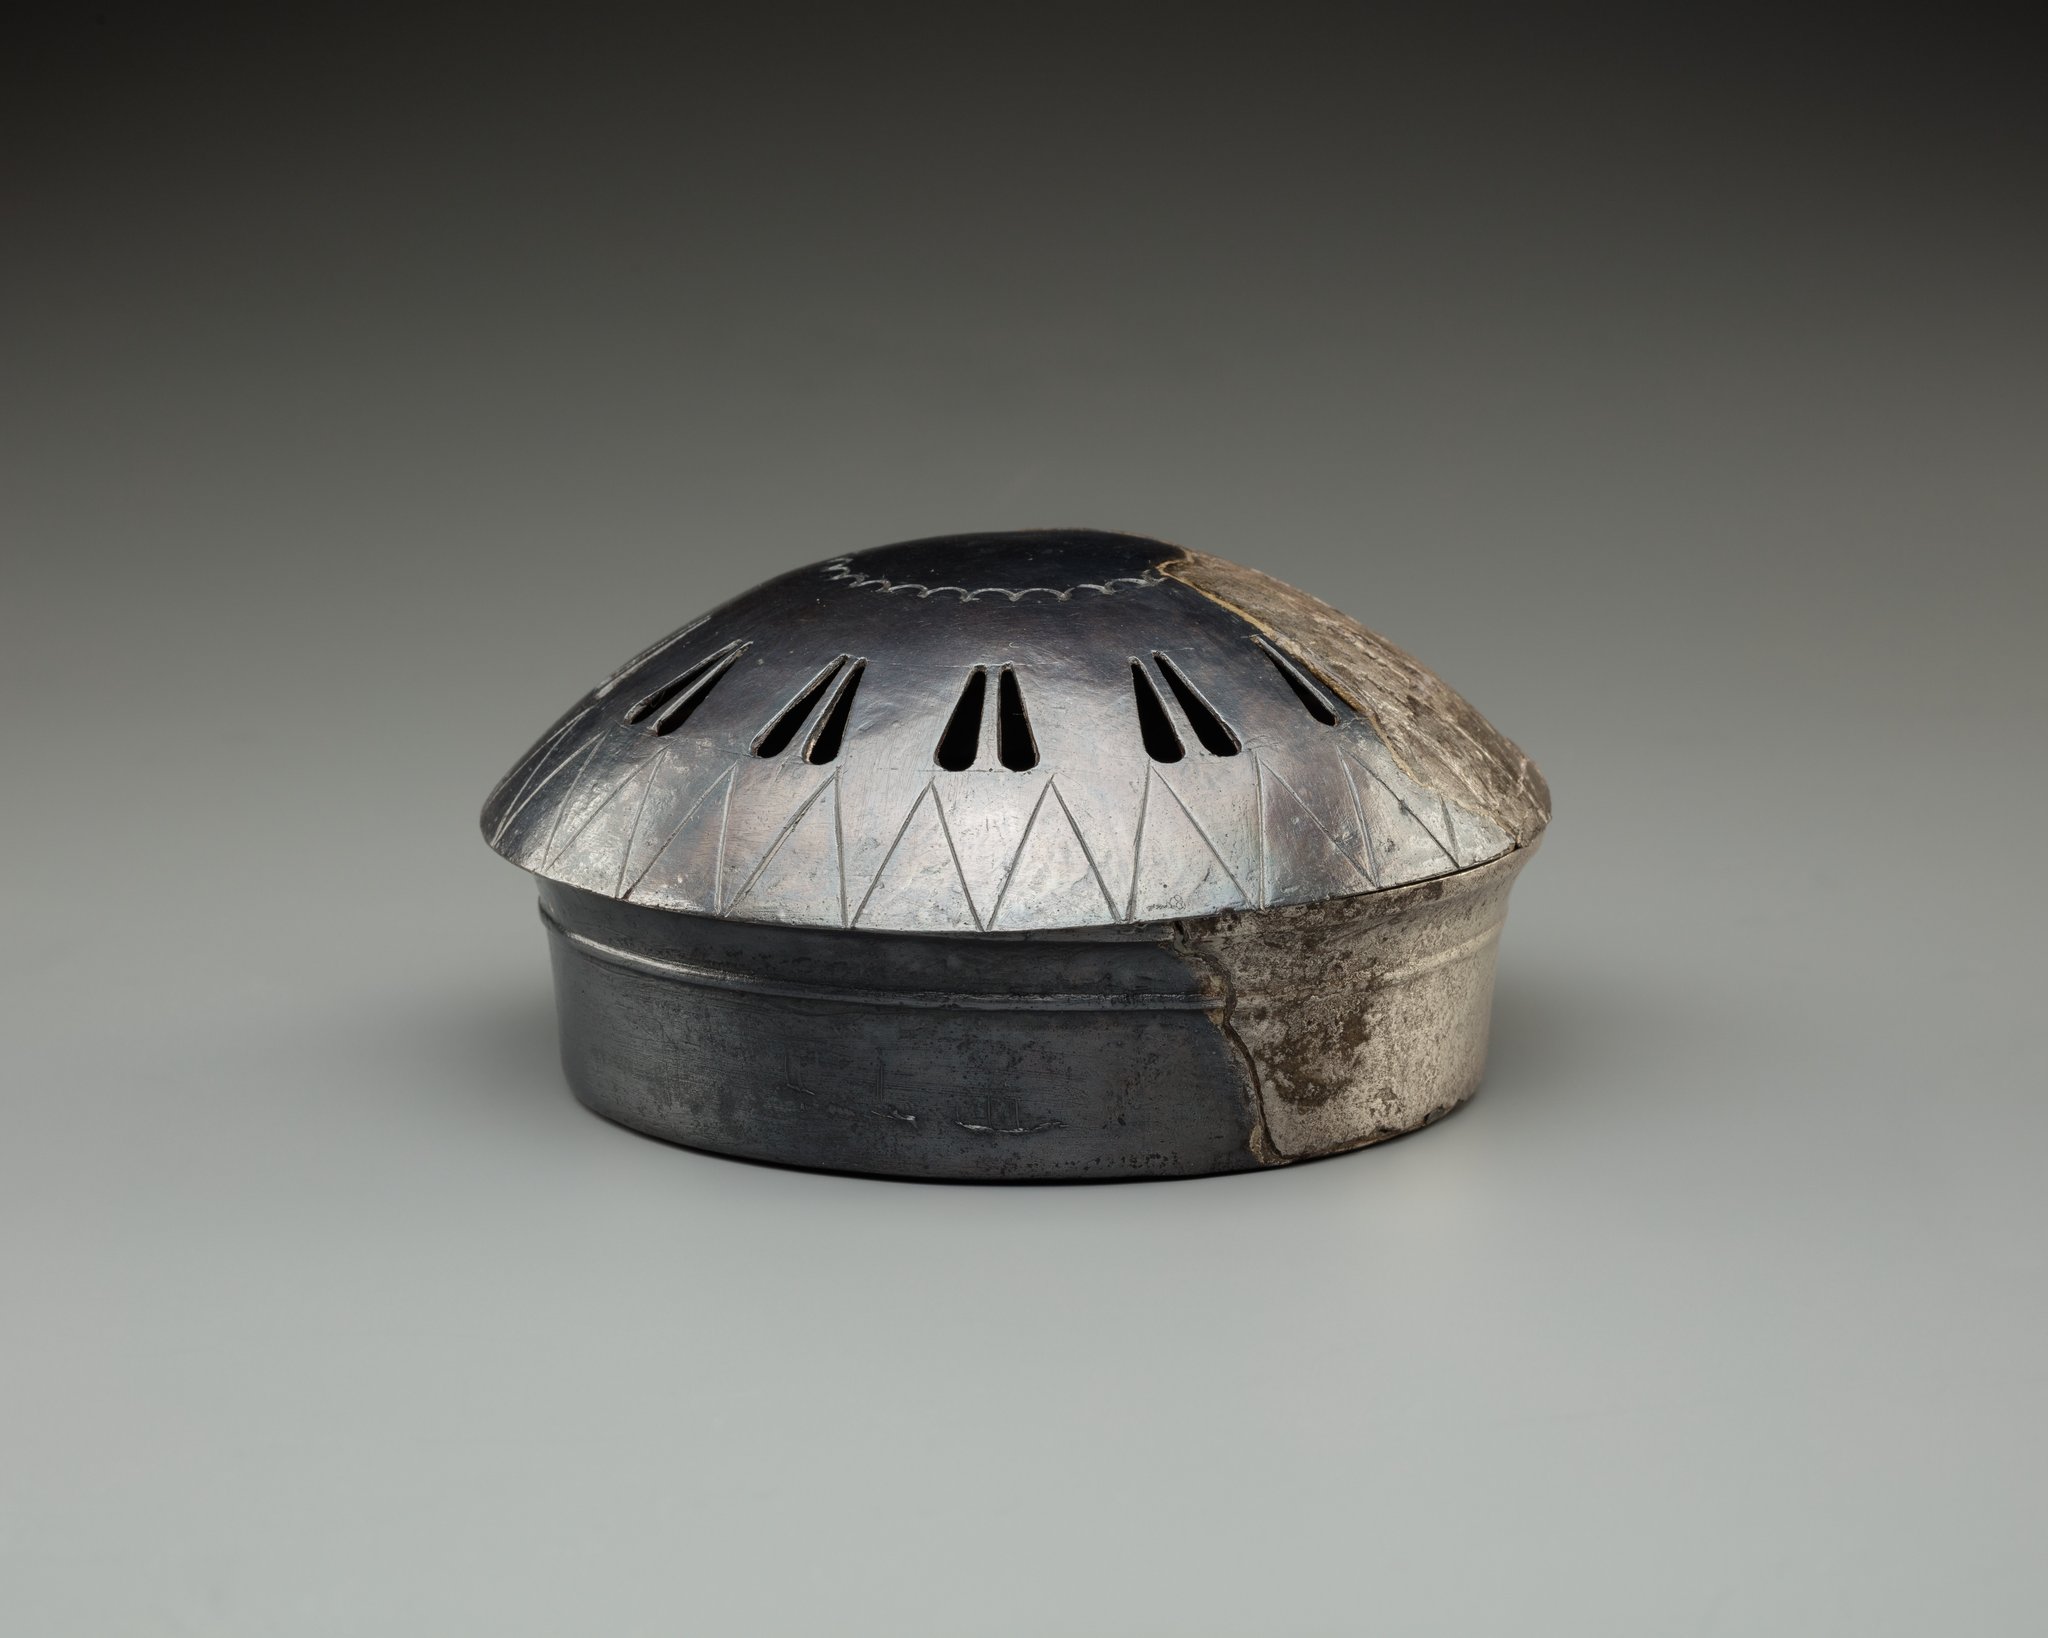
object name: incense burner, chain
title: Incense burner with its chain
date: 304-30 BCE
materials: silver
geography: egypt